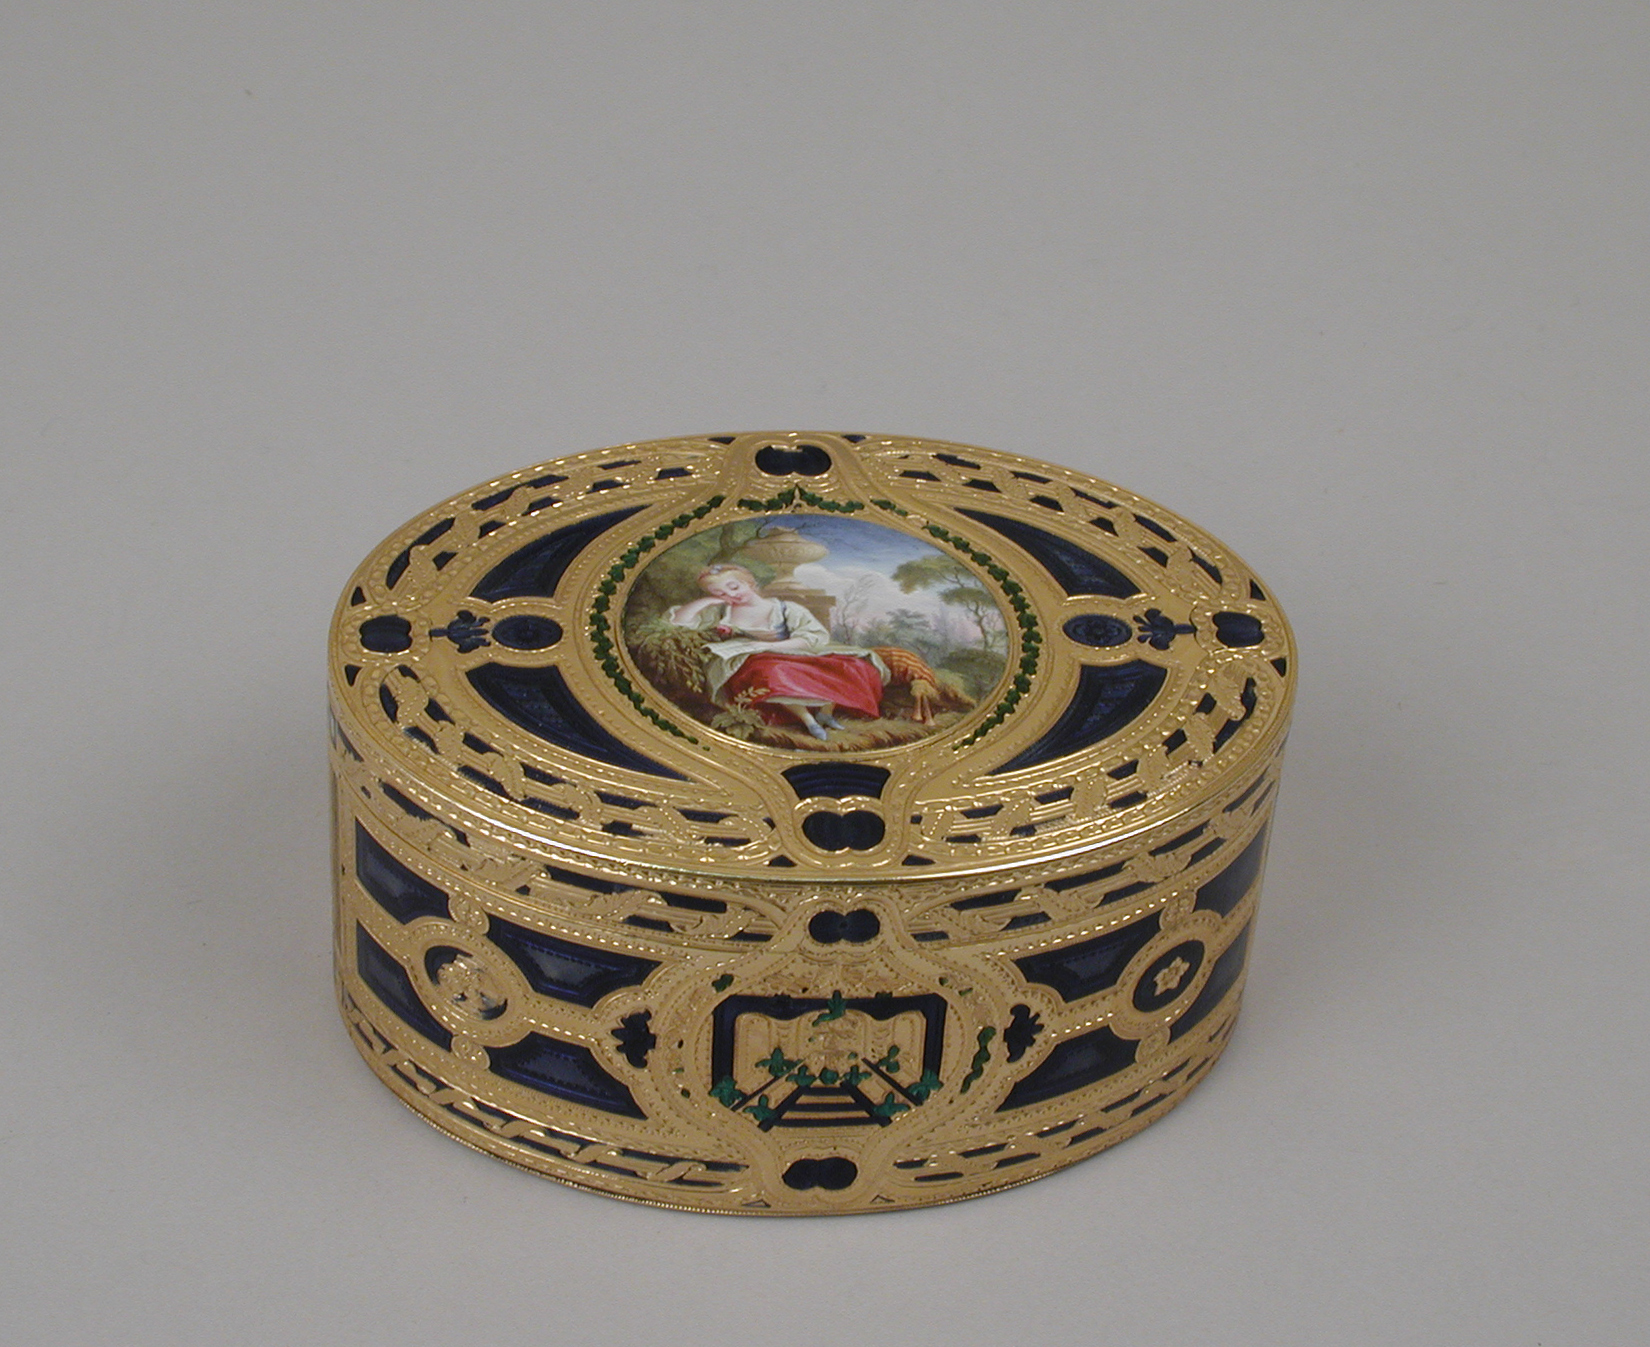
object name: snuffbox, painting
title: Snuffbox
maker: claude perron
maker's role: maker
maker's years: 1677-1777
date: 1763-1764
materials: enamel, gold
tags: women